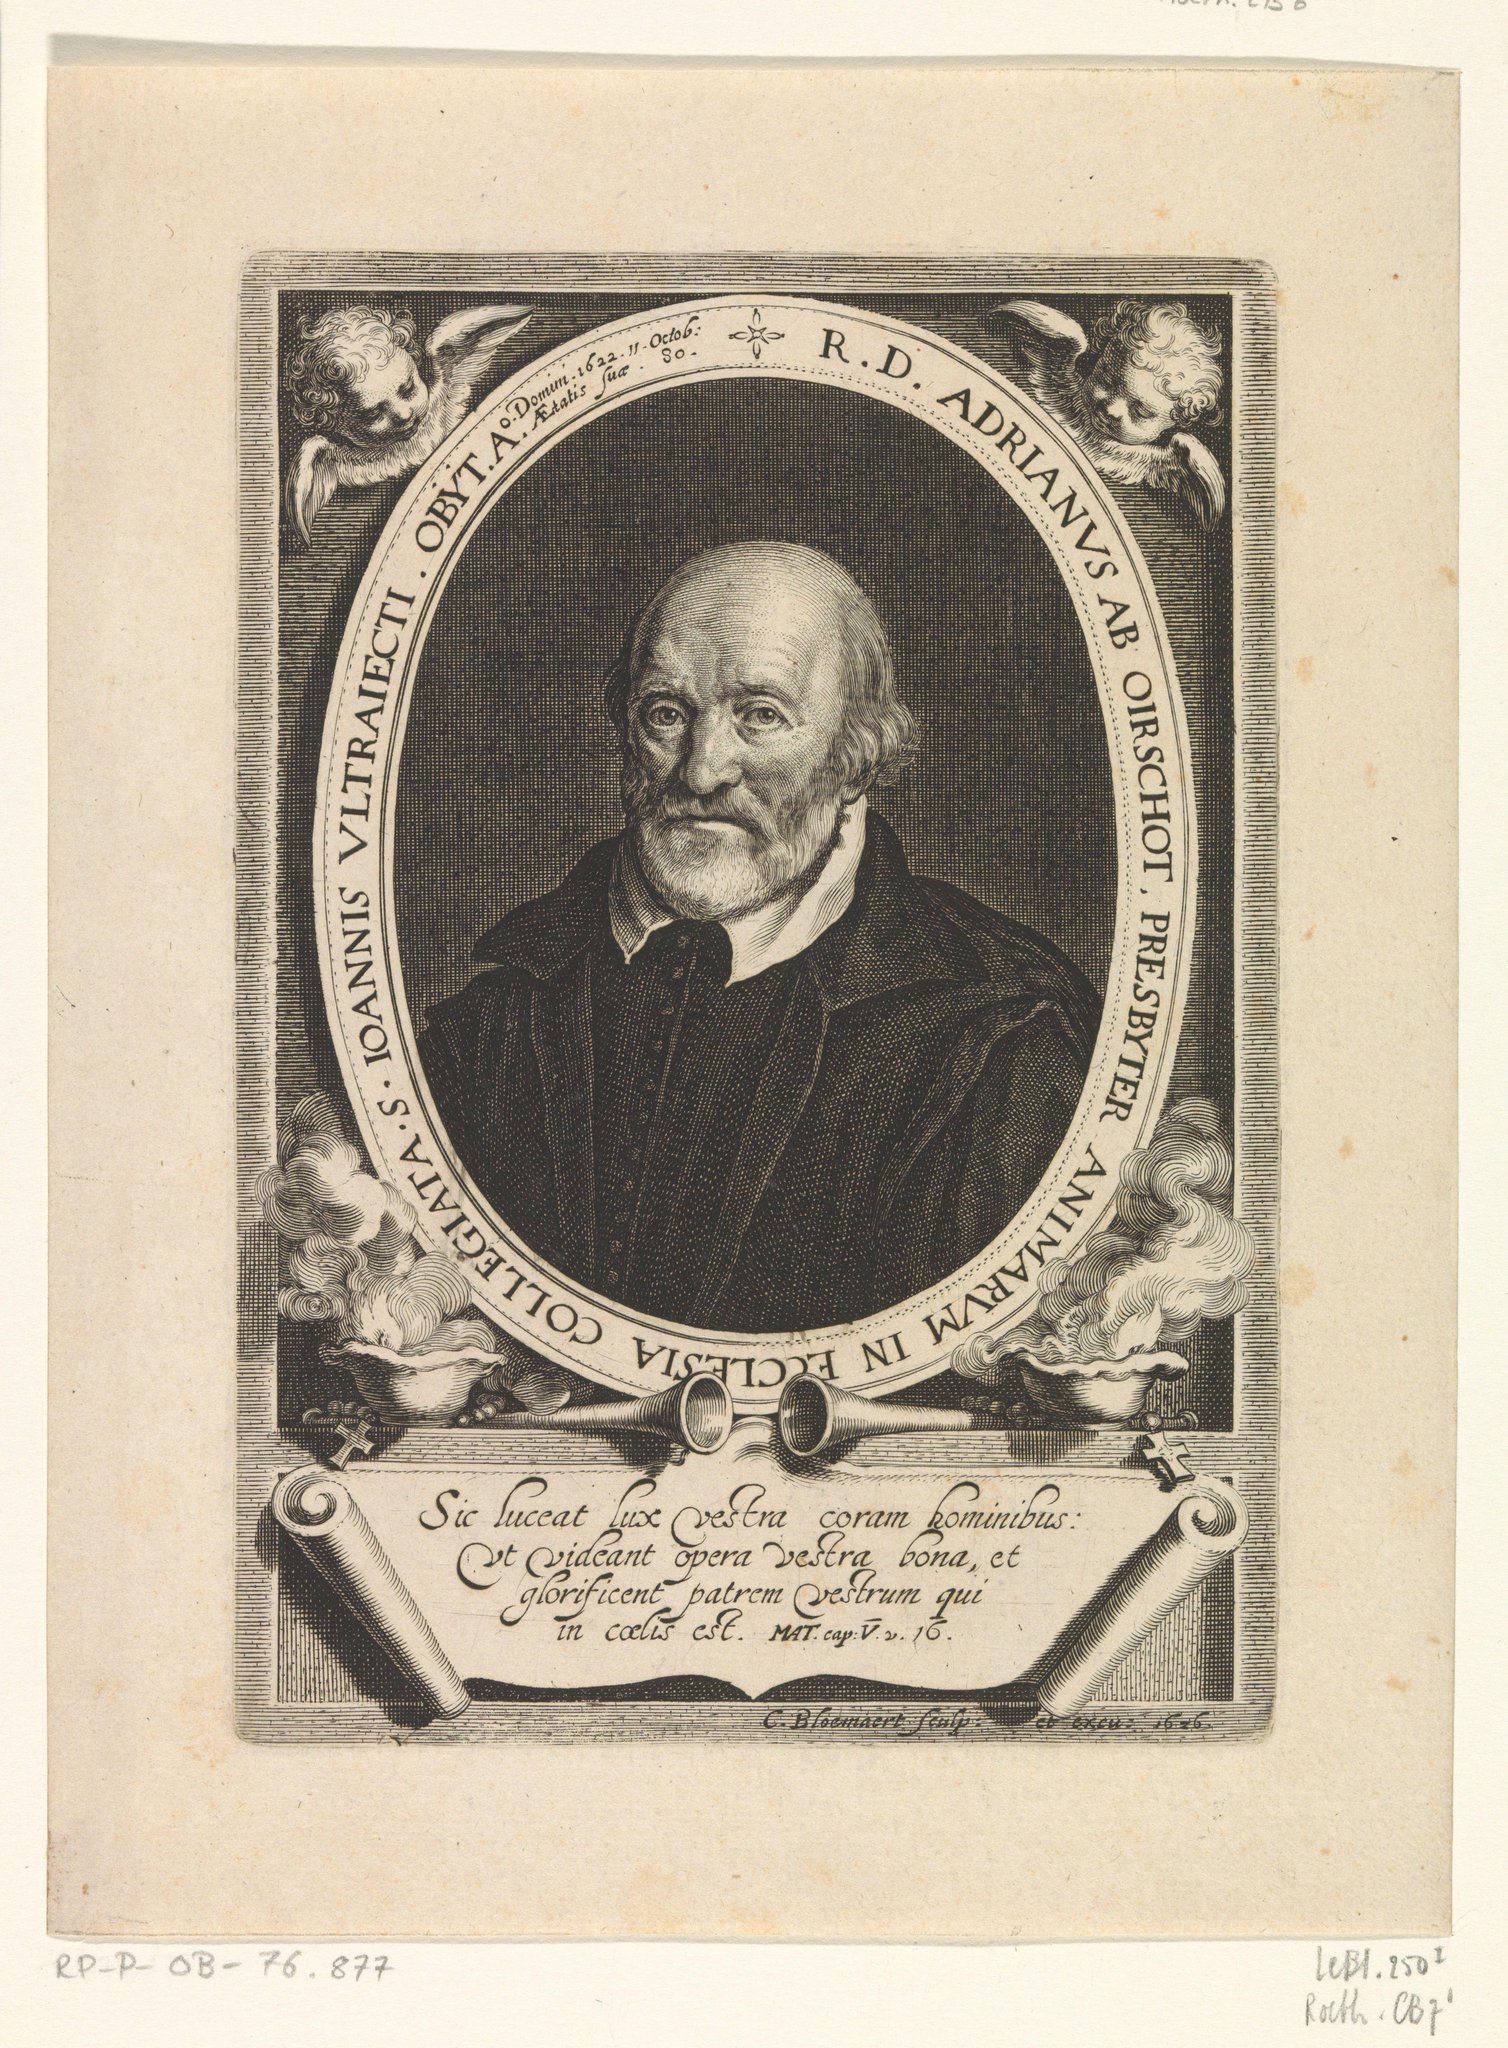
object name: print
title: Portret van Adriaen van Oorschot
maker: cornelis bloemaert (ii)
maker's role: draughtsman, print maker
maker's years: 1603-1692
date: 1626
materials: paper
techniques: engraving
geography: utrecht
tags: priest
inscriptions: collector's mark: Lugt 2228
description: Portret van de Utrechtse theoloog Adriaen van Oorschot, in ovaal met randschrift. De brandende schalen verwijzen naar de dood van de geportretteerde. Onder het portret een citaat uit de bijbel in het Latijn.